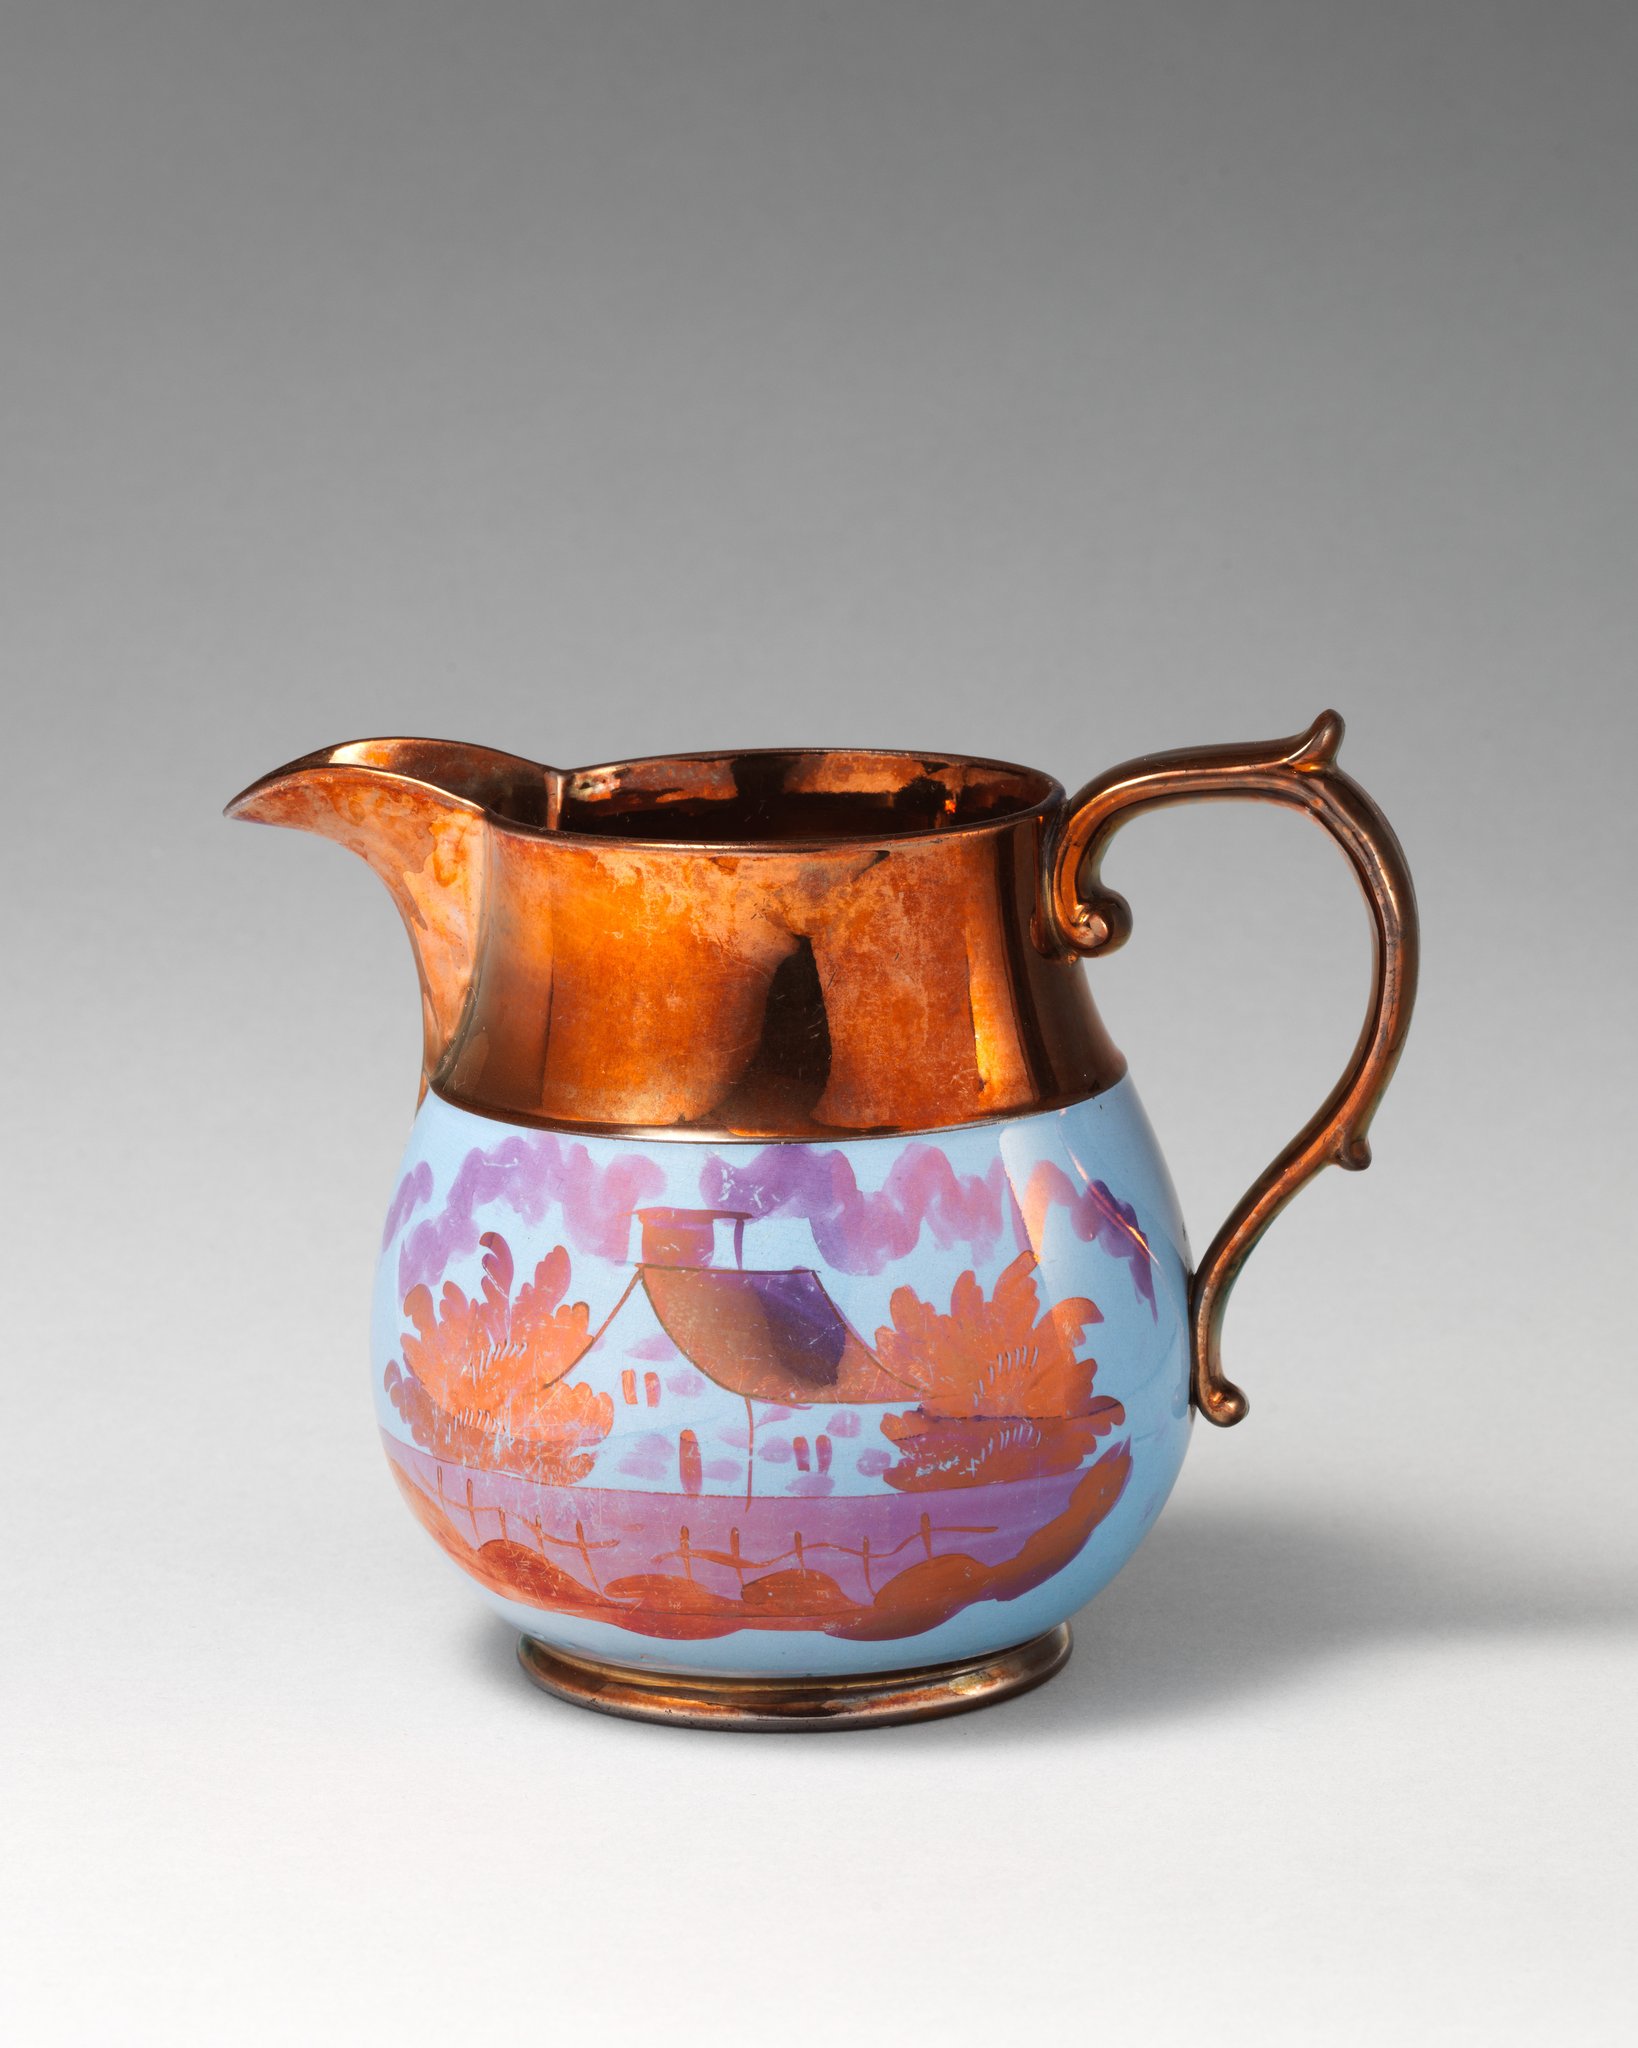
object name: pitcher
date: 1801-1900